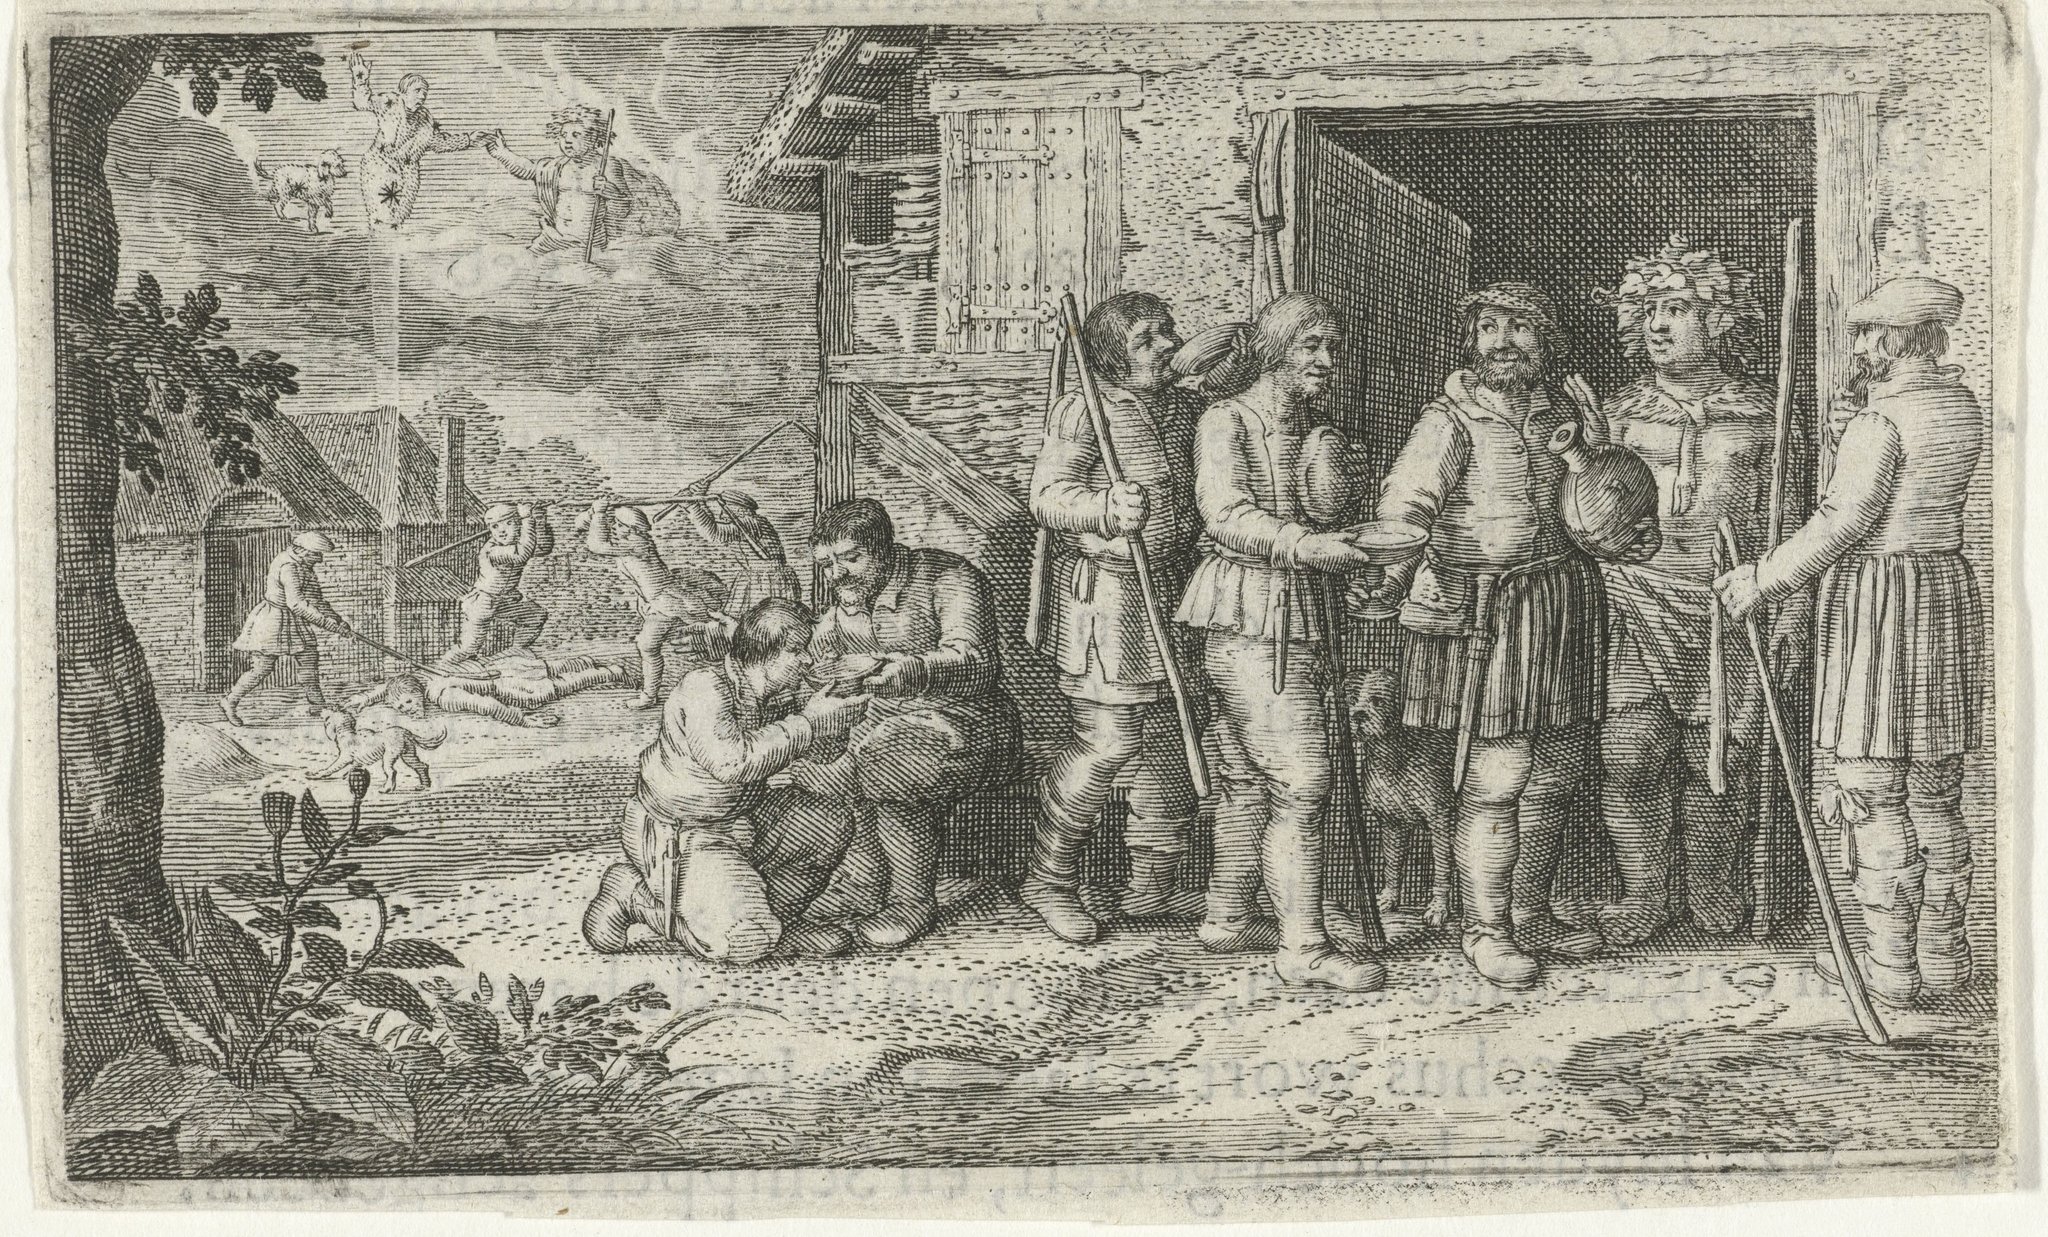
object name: print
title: Bacchus met wijn bij boeren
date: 1616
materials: paper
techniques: engraving, letterpress printing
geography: amsterdam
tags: icarius changed into a constellation: after having been slain by angry farmers, icarius is changed into a constellation (ovid, metamorphoses x 450), (story of) bacchus (dionysus), liber, farmers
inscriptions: collector's mark: Lugt 2228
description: Boekillustratie voor: Heinsius, Daniel [bewerkt door Petrus Scriverius]. Nederduytsche poemata. dl. 3: Hymnus oft Lof-sanck van Bacchus, Waerin'tgebruyck ende misbruyck vande Wijn beschreven wort. Amsterdam: Willem Jansz Blaeu, 1616.